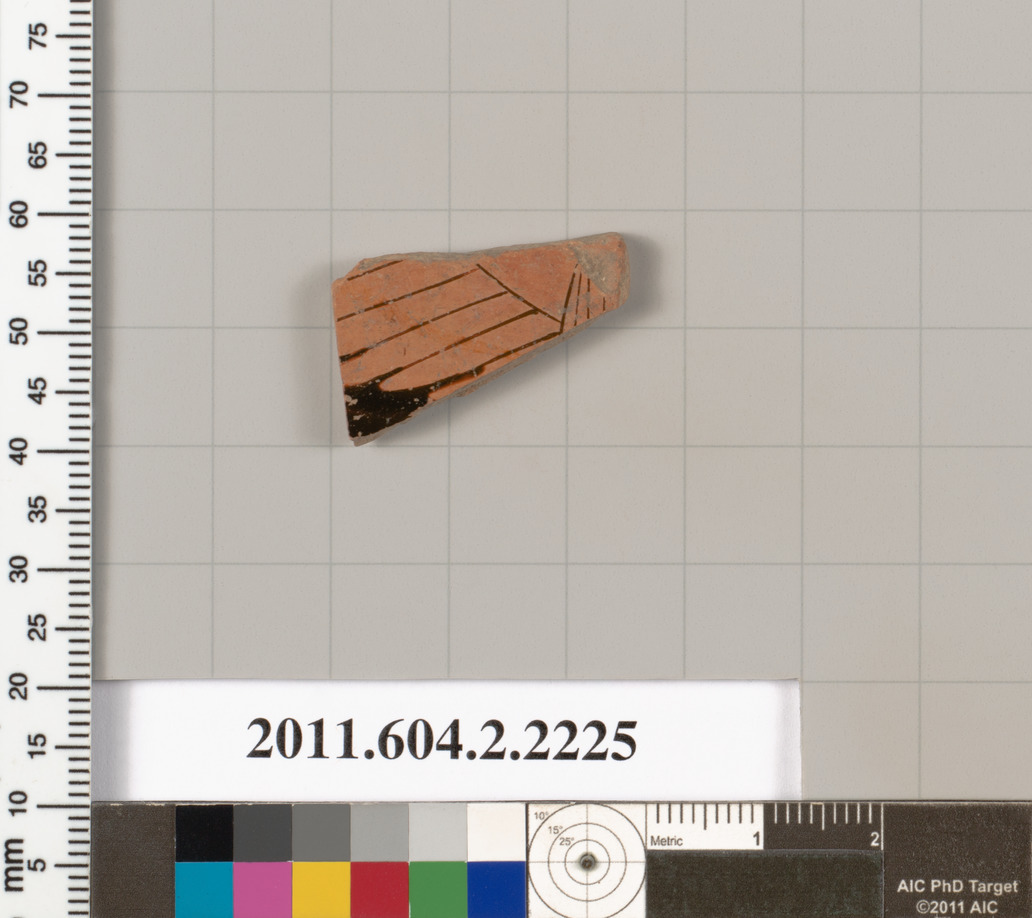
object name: pot fragment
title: Terracotta fragment of a pot; unglazed on the inside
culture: greek, attic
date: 475-451 BCE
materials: terracotta